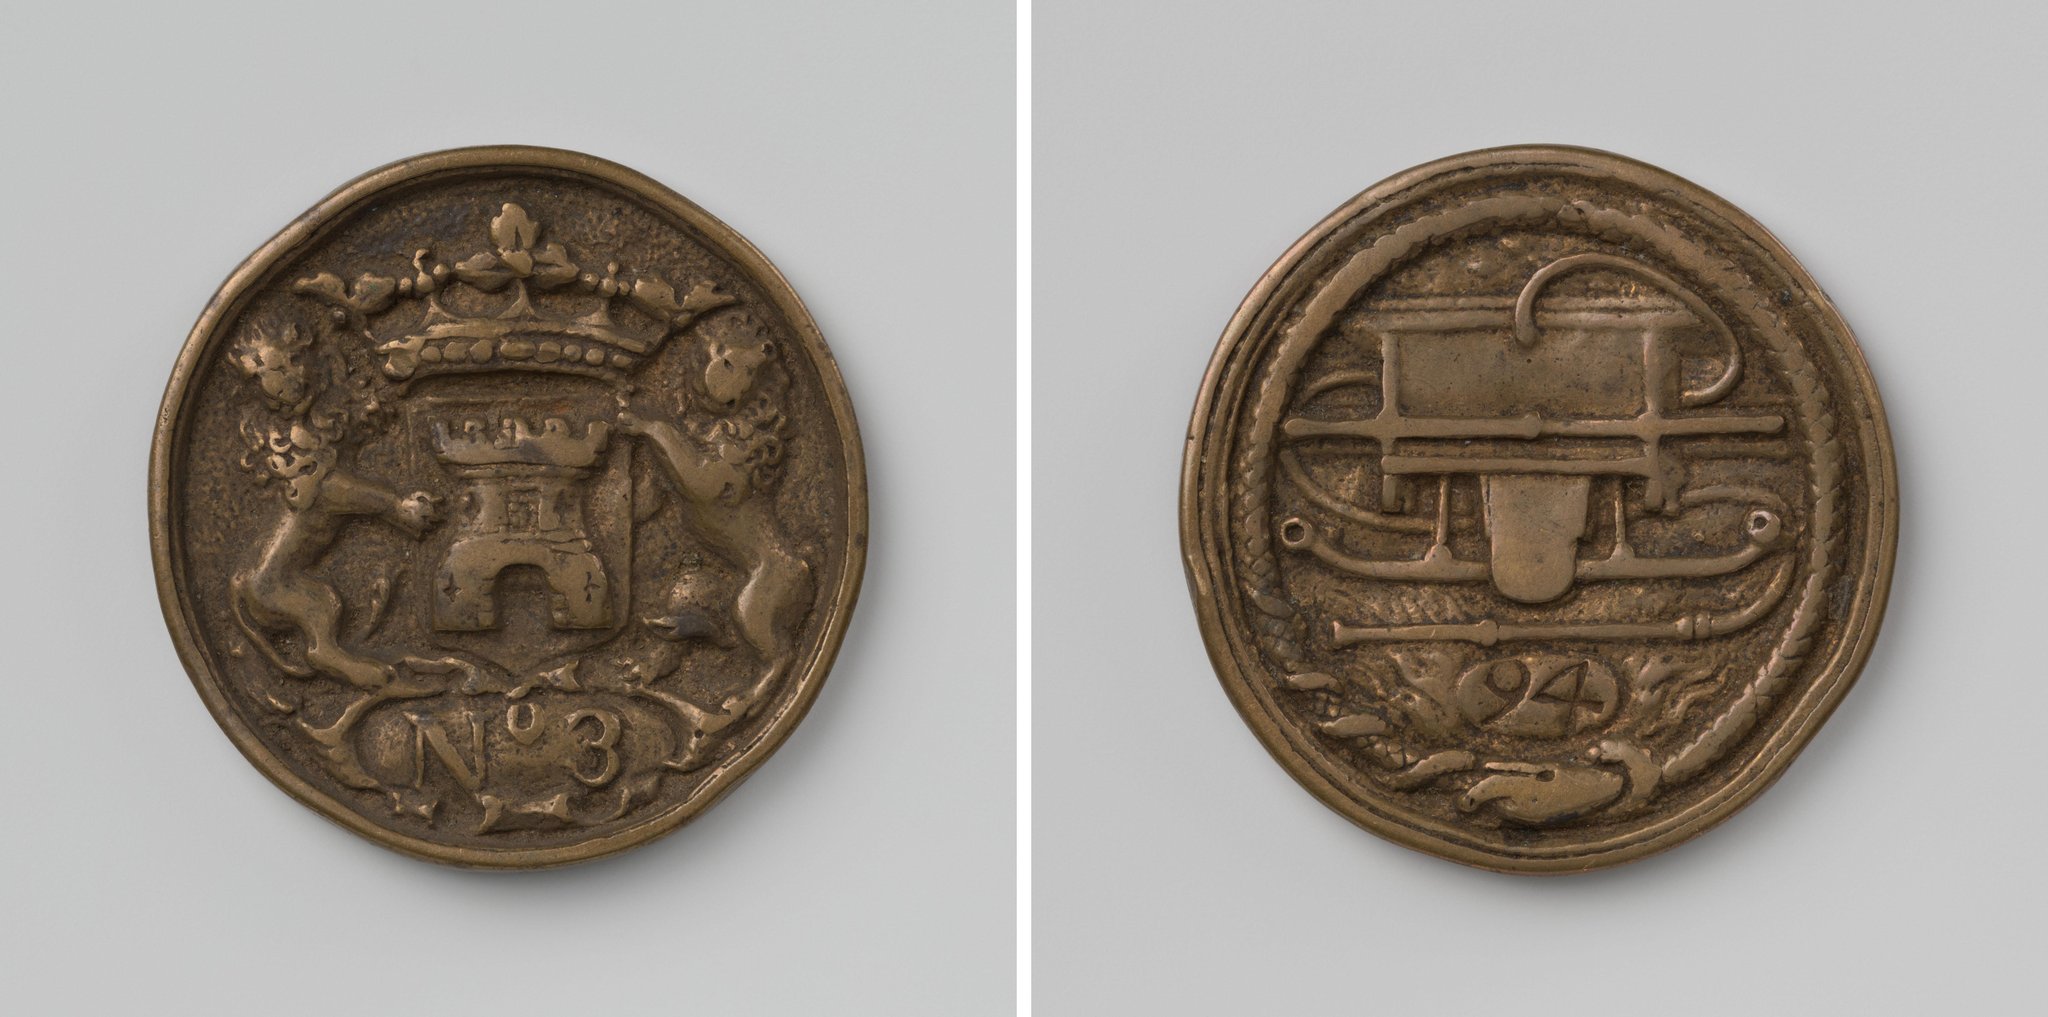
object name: medal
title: Alkmaar, brandspuitpenning van spuit 3 met no. 94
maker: Anonymous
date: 1680-1800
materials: brass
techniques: casting, engraving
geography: alkmaar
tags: alkmaar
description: Messing penning. Voorzijde: gekroond wapenschild, geflankeerd door twee leeuwen boven cartouche met cijfer No. 3. Keerzijde: brandpuit onder cartouche met op kop geplaatst cijfer 94 binnen slangerond